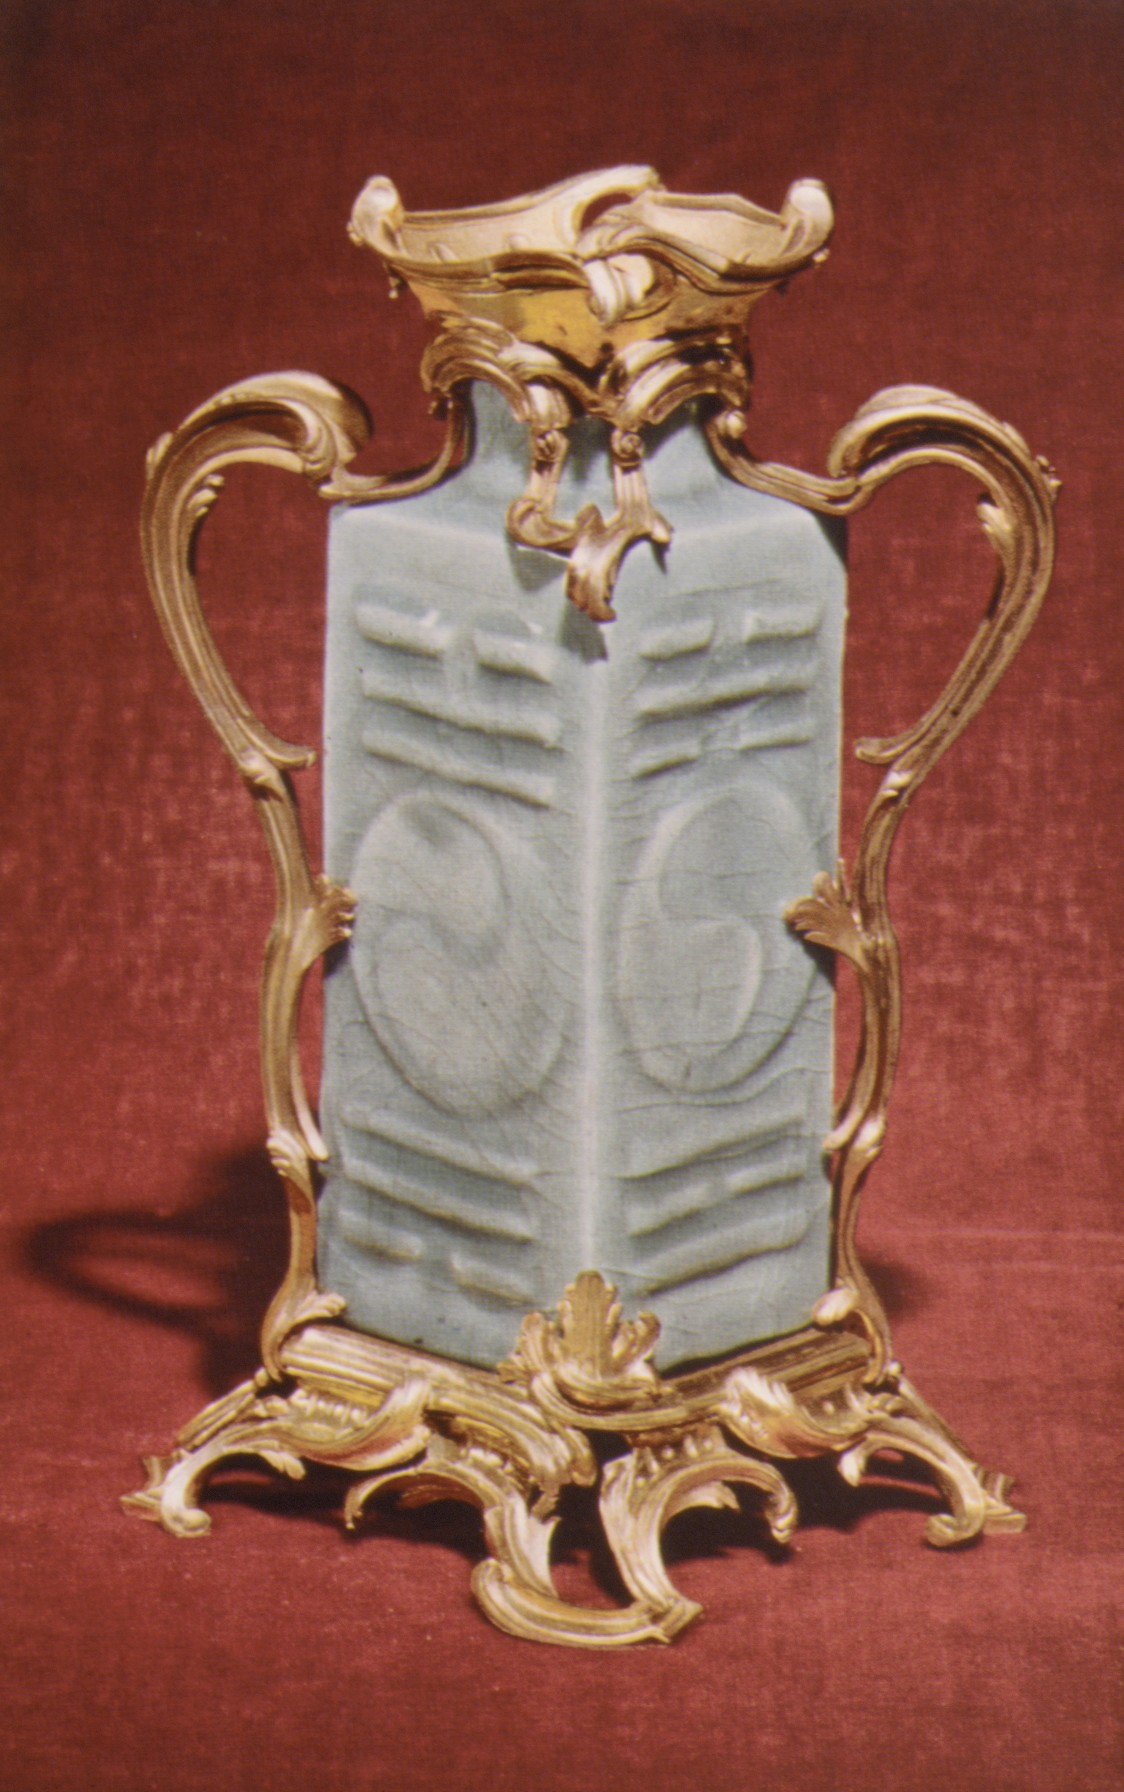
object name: vase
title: Pair of vases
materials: gilt bronze, hard paste porcelain